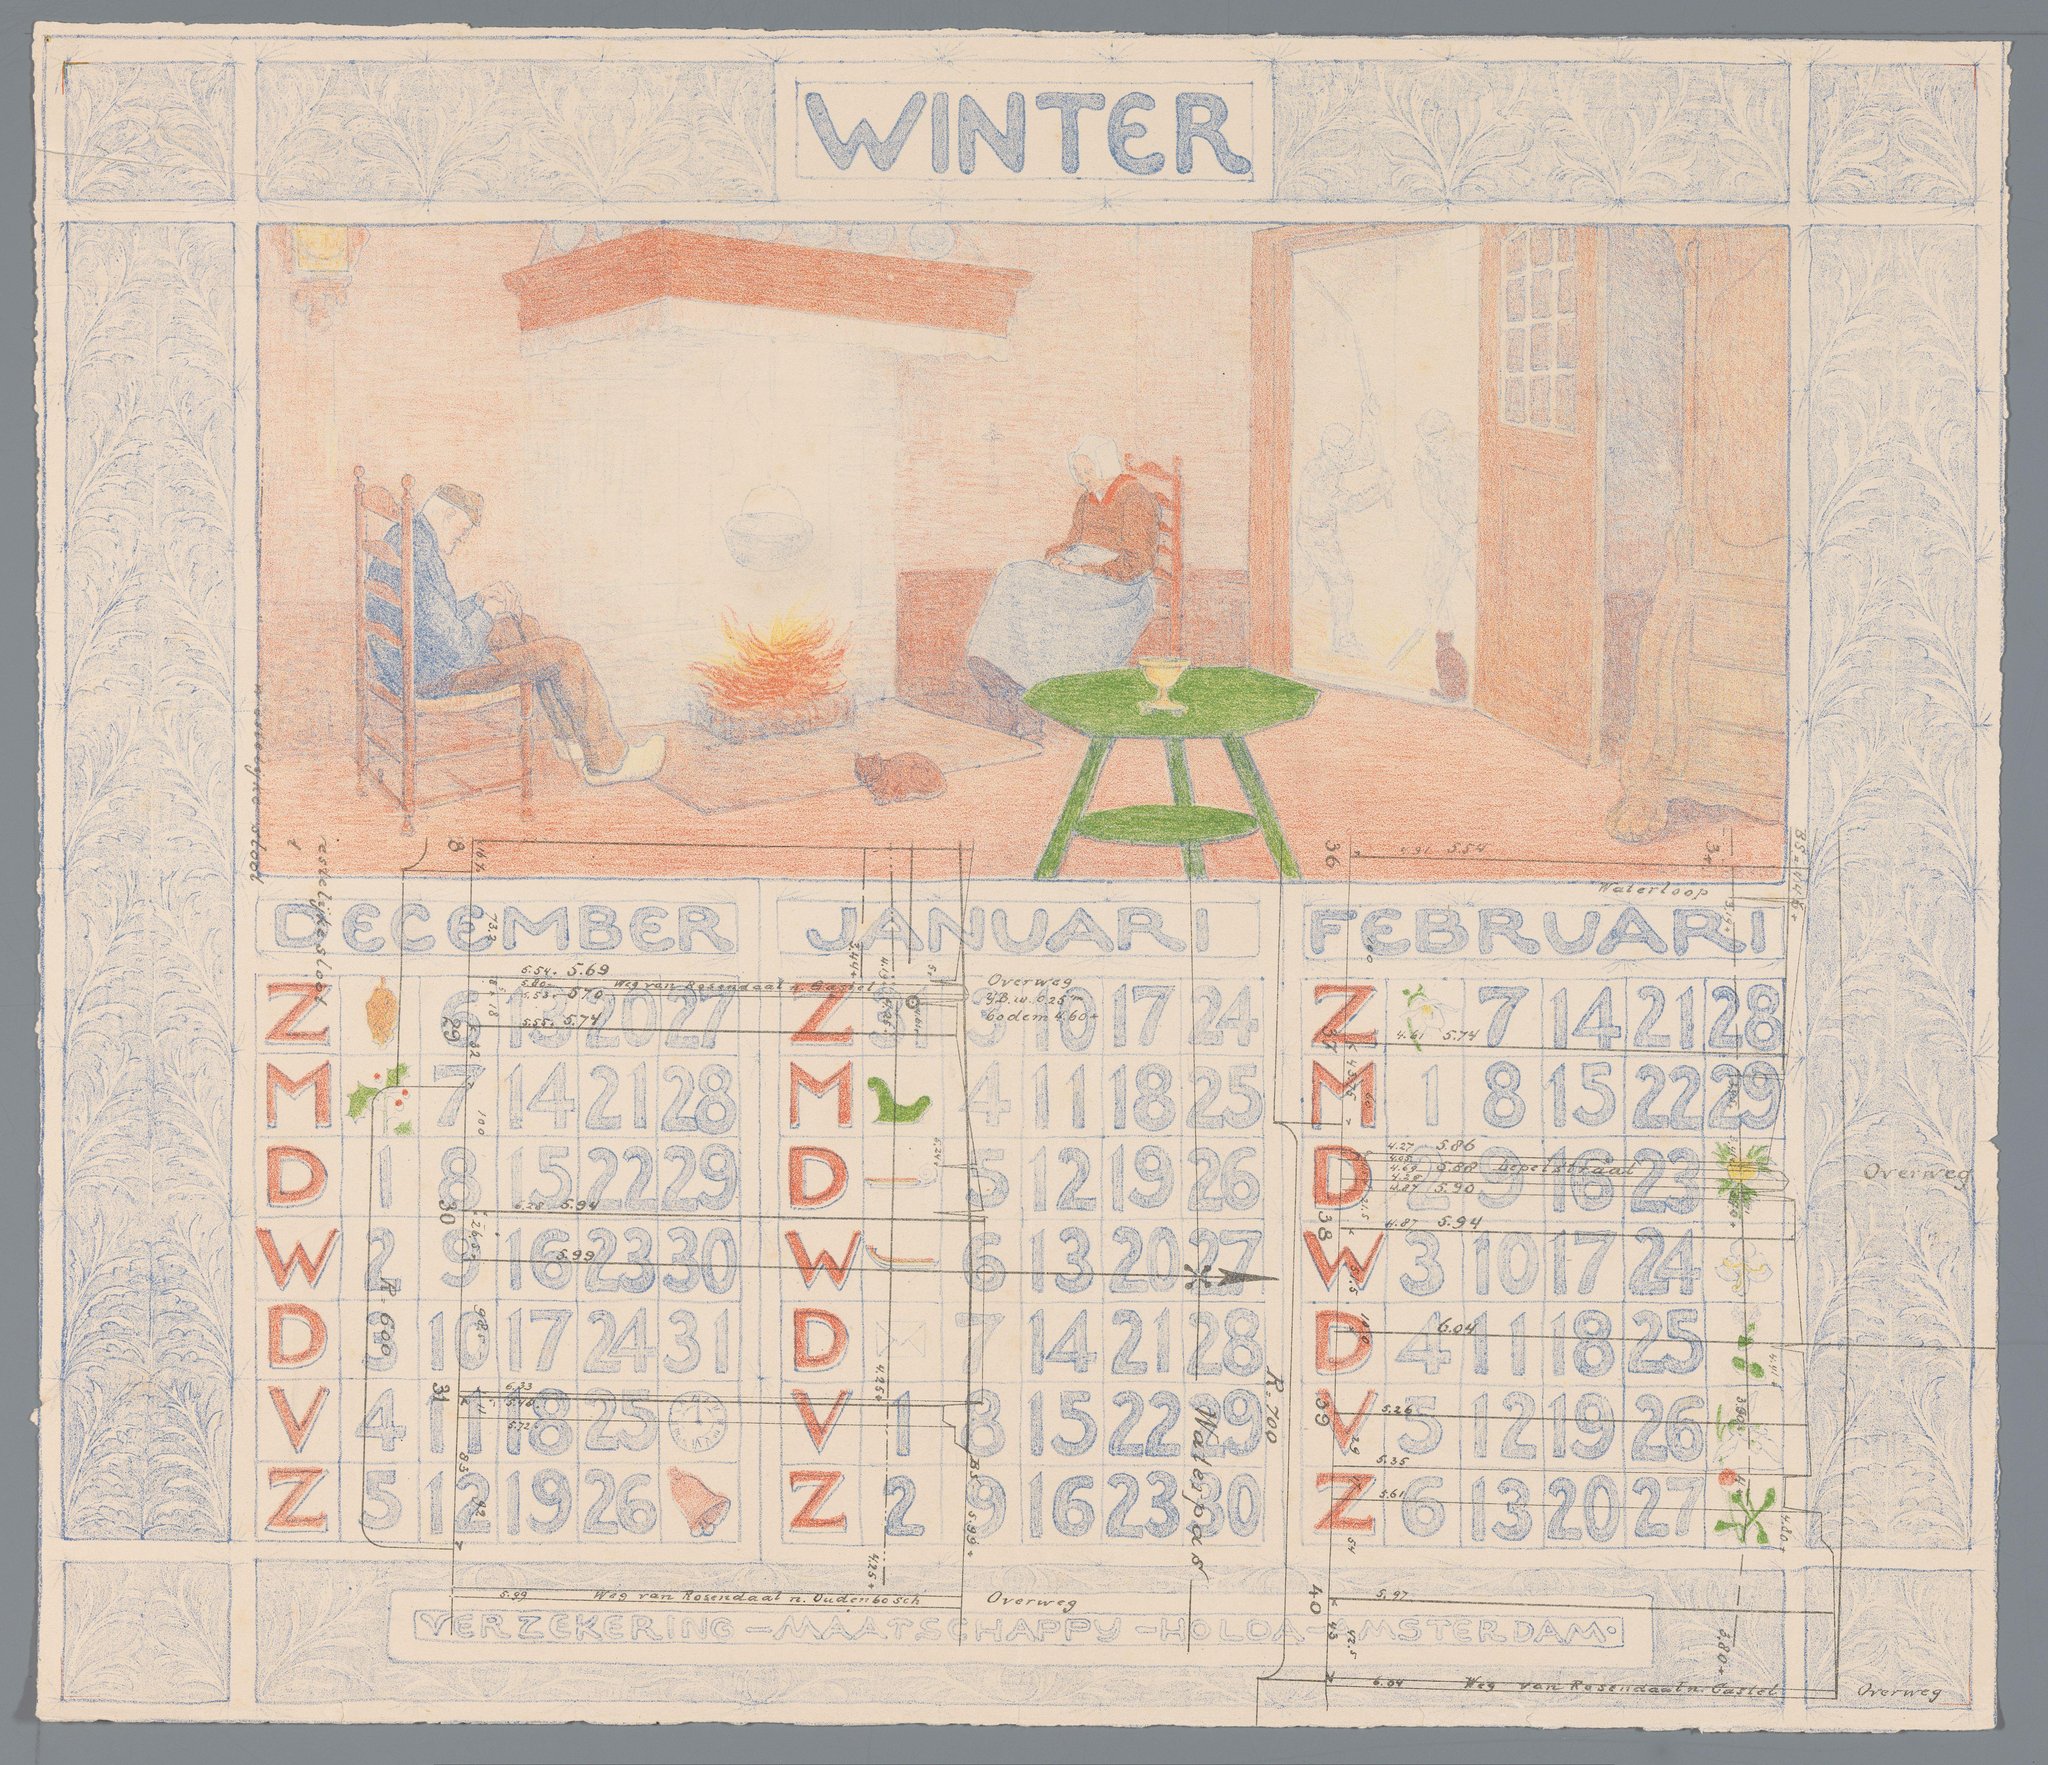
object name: calendar leaf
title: Kalenderblad voor winter 1903-1904 van de Verzekering-Maatschappij Holda in Amsterdam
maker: ferdinand hart nibbrig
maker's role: draughtsman, painter, print maker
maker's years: 1866-1915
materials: paper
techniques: lithograph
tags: cat, open hearth, fire-place, farmers, winter ~ human activities (the four seasons of the year)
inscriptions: collector's mark: Lugt 2228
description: Een rechthoekig kader opgevuld met de dagen van de maanden december, januari en februari en daarboven een boer en boerin, zittend bij een haardvuur met één van hun katten. In de deuropening nog een kat, die naar twee mannen kijkt die in een stal aan het werk zijn. Op recto zijn ook berekeningen over wegen tussen de Noord-Brabantse plaatsen Roosendaal, Gastel, Oudenbosch en Lepelstraat gedrukt.